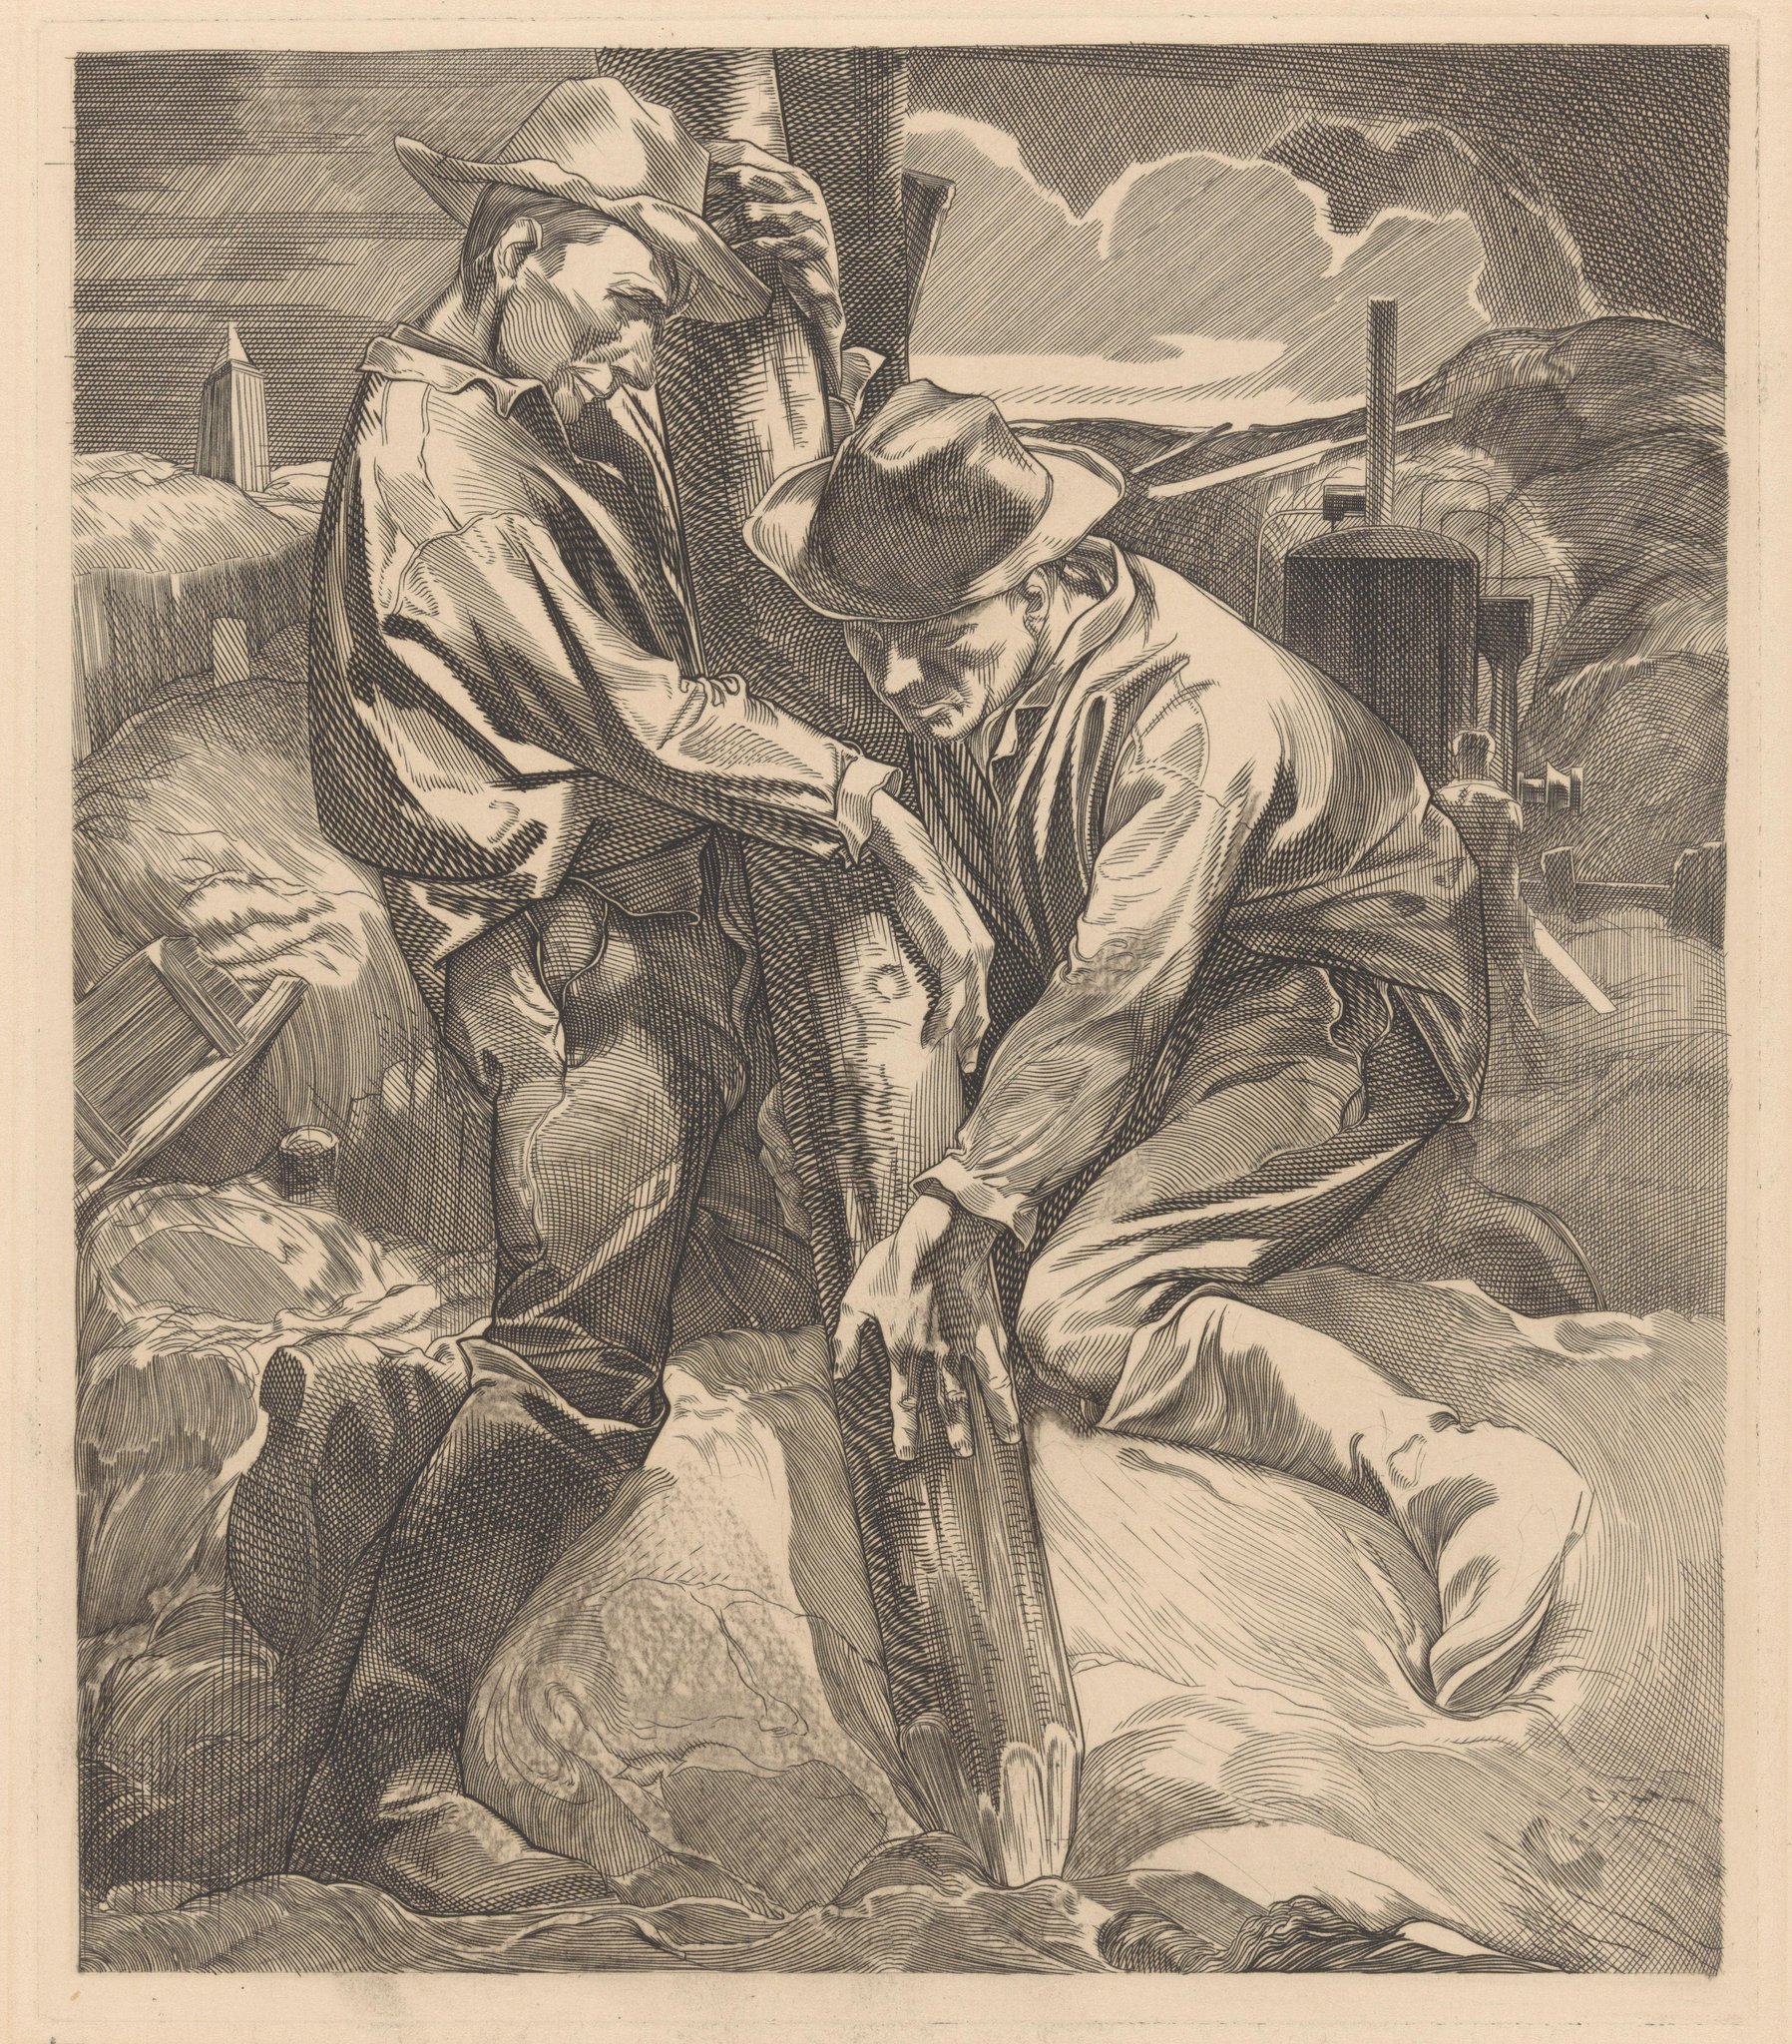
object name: print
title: Bouwarbeiders bezig met heiwerk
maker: johannes josephus aarts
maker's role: draughtsman, print maker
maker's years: 1871-1934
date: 1881-1934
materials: chalk, paper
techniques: engraving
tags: ramming, driving piles (~ building activities), working class, labourers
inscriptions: collector's mark: Lugt 2760, collector's mark: Lugt 2166, collector's mark: Lugt 2228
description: Twee arbeiders plaatsen samen een paal in de grond. Ze dragen beiden een hoed. Rechtsachter hen een machine en een andere arbeider.